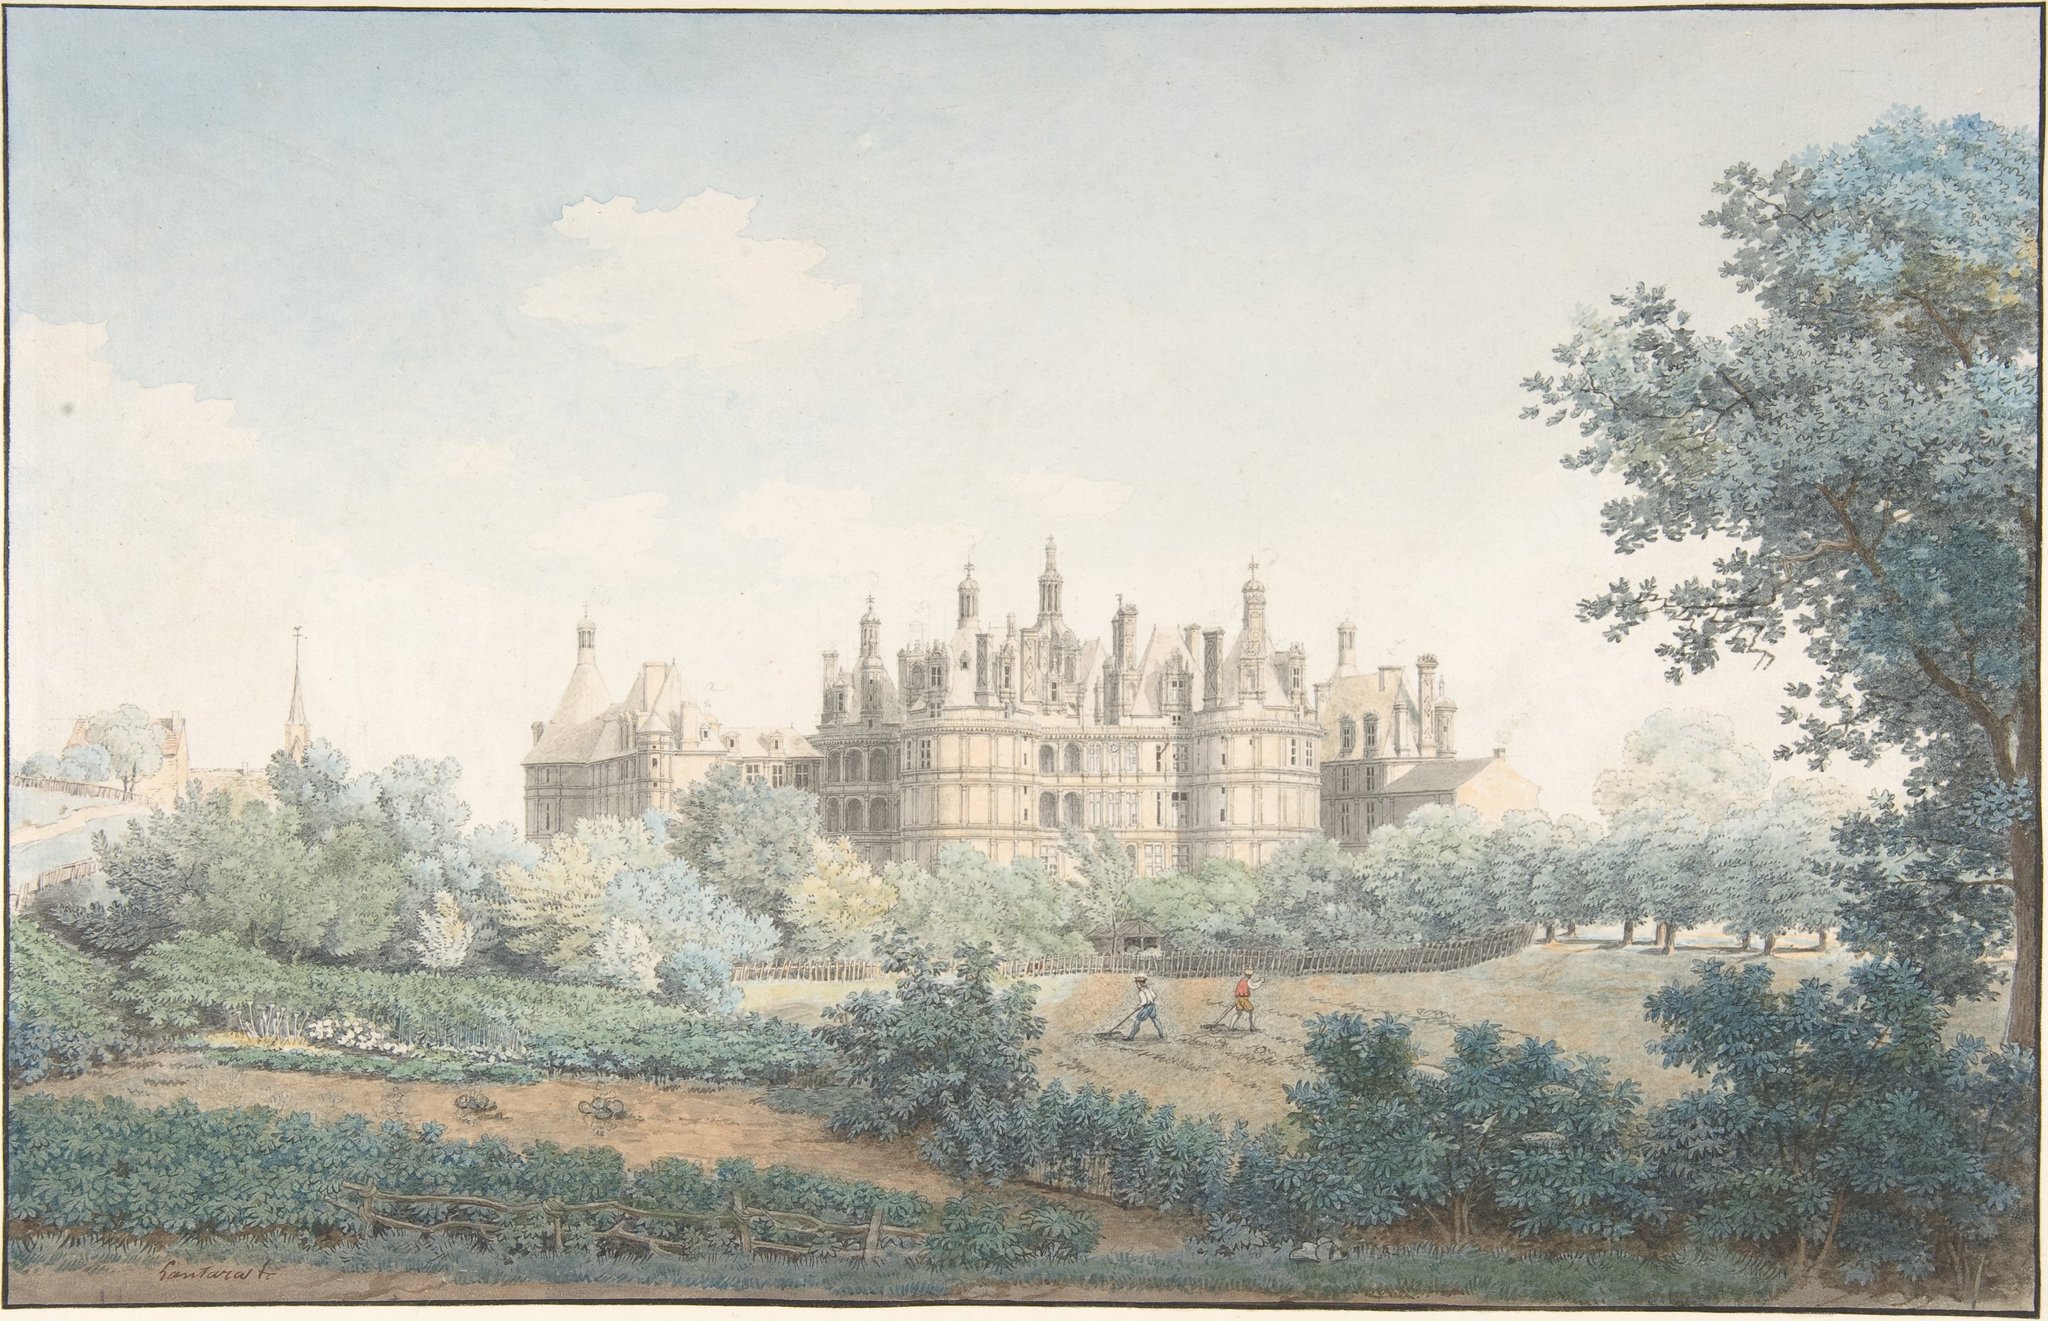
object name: drawing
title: The Château of Chambord Seen from the Southwest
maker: simon mathurin lantara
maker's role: artist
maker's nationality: french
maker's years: 1729-1778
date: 1701-1800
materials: graphite, ink, watercolor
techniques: pen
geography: france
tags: buildings,men,trees